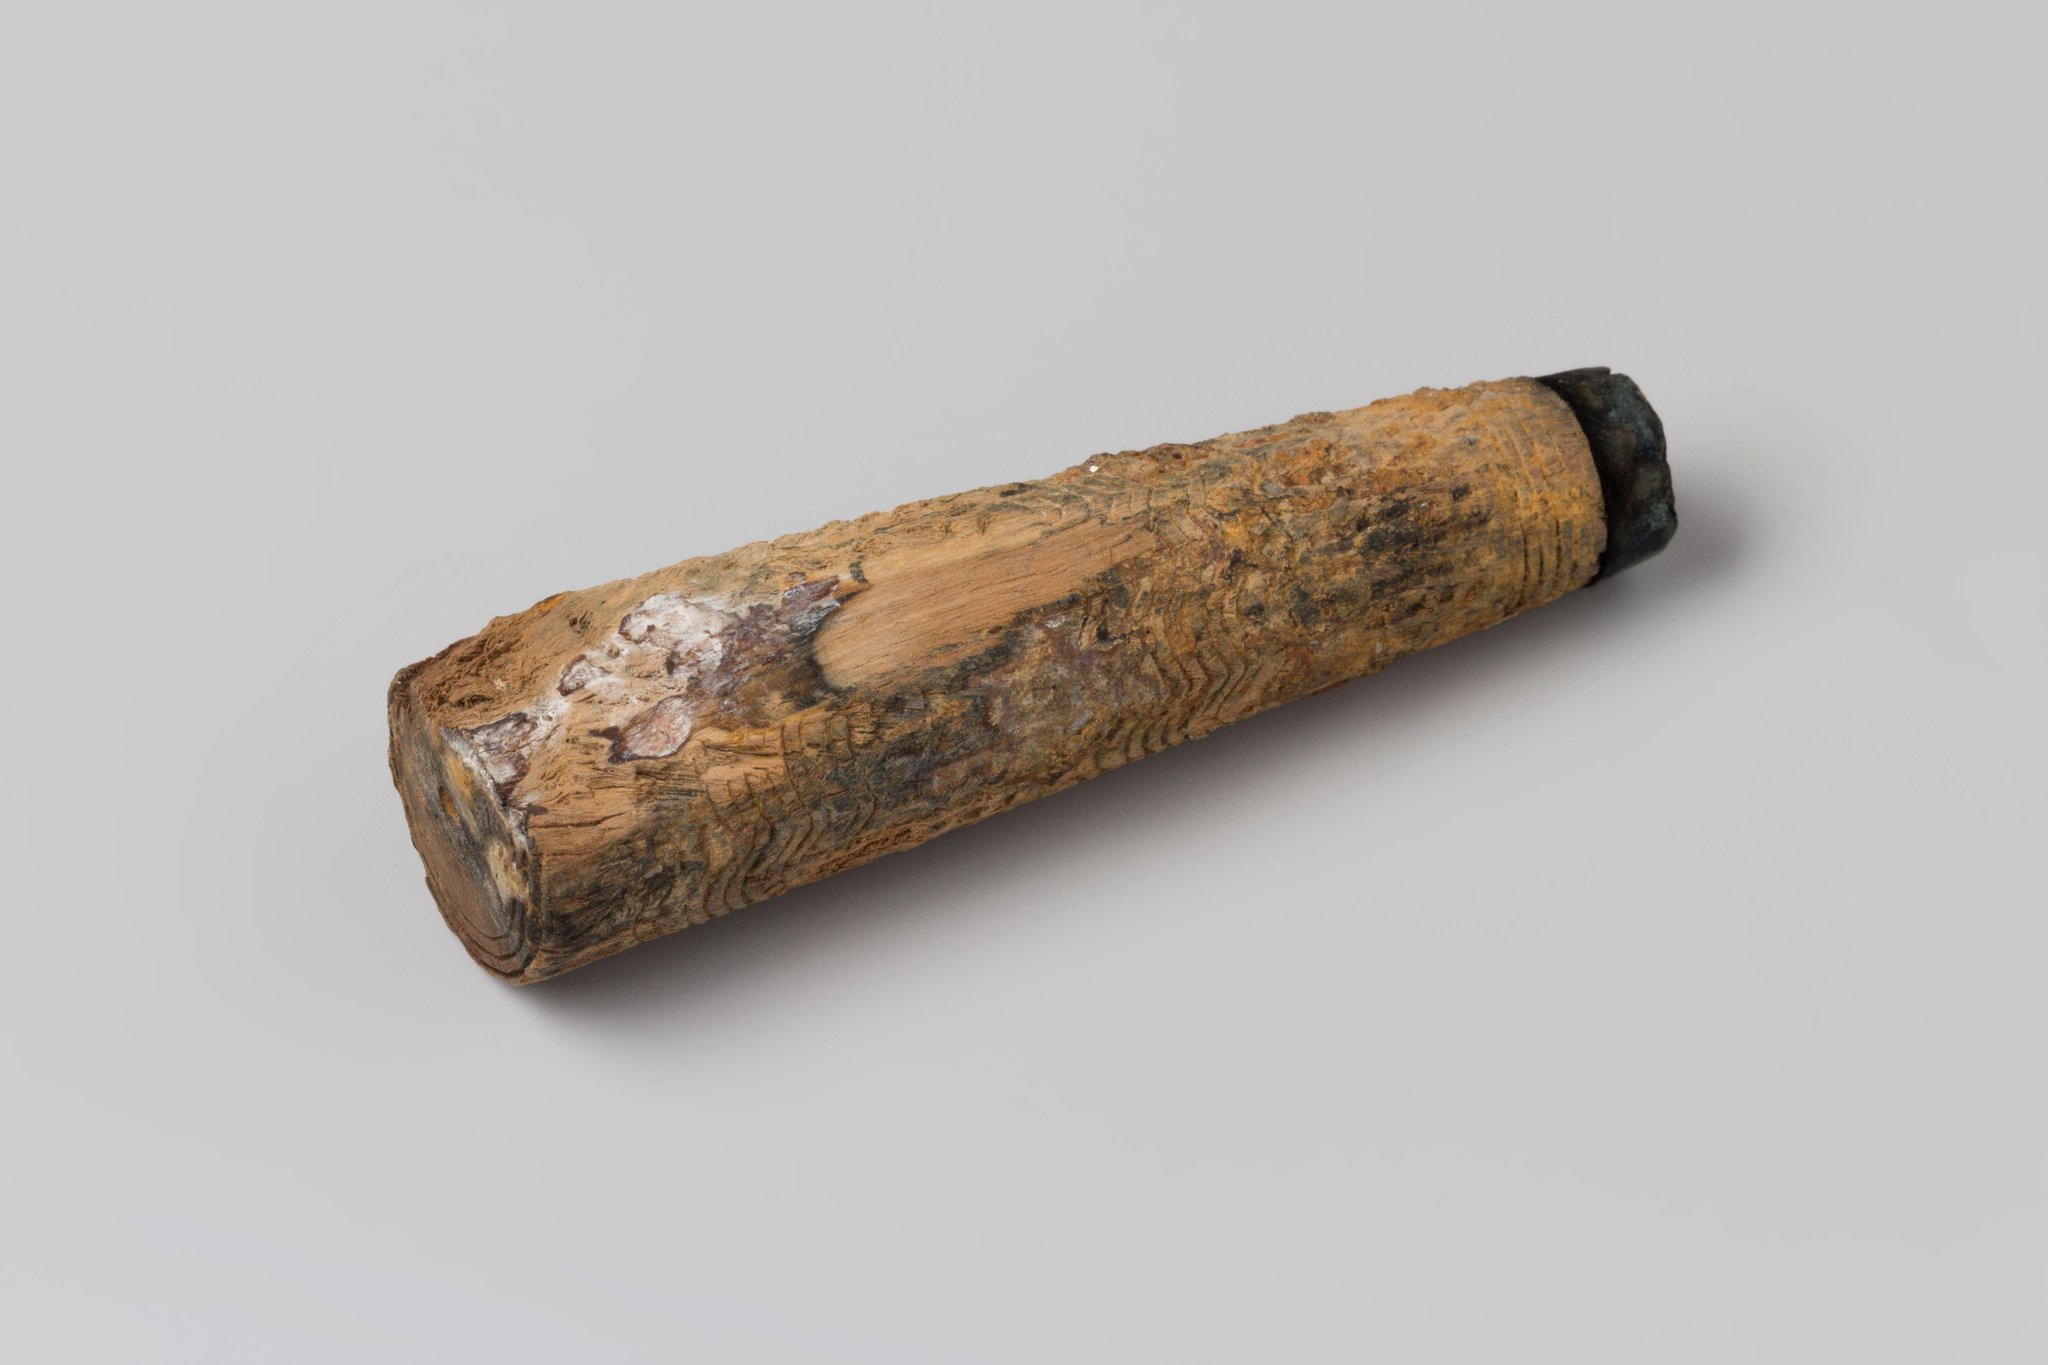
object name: knife handle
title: Messenheft uit het wrak van de Oost-Indiëvaarder Hollandia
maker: Anonymous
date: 1700-1743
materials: copper, wood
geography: netherlands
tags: verenigde oostindische compagnie, hollandia (schip), annet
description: Knife, handle, cylindrical: tapering; id. NG 1979-403H, ferrules, id. NG 1980-27H426.